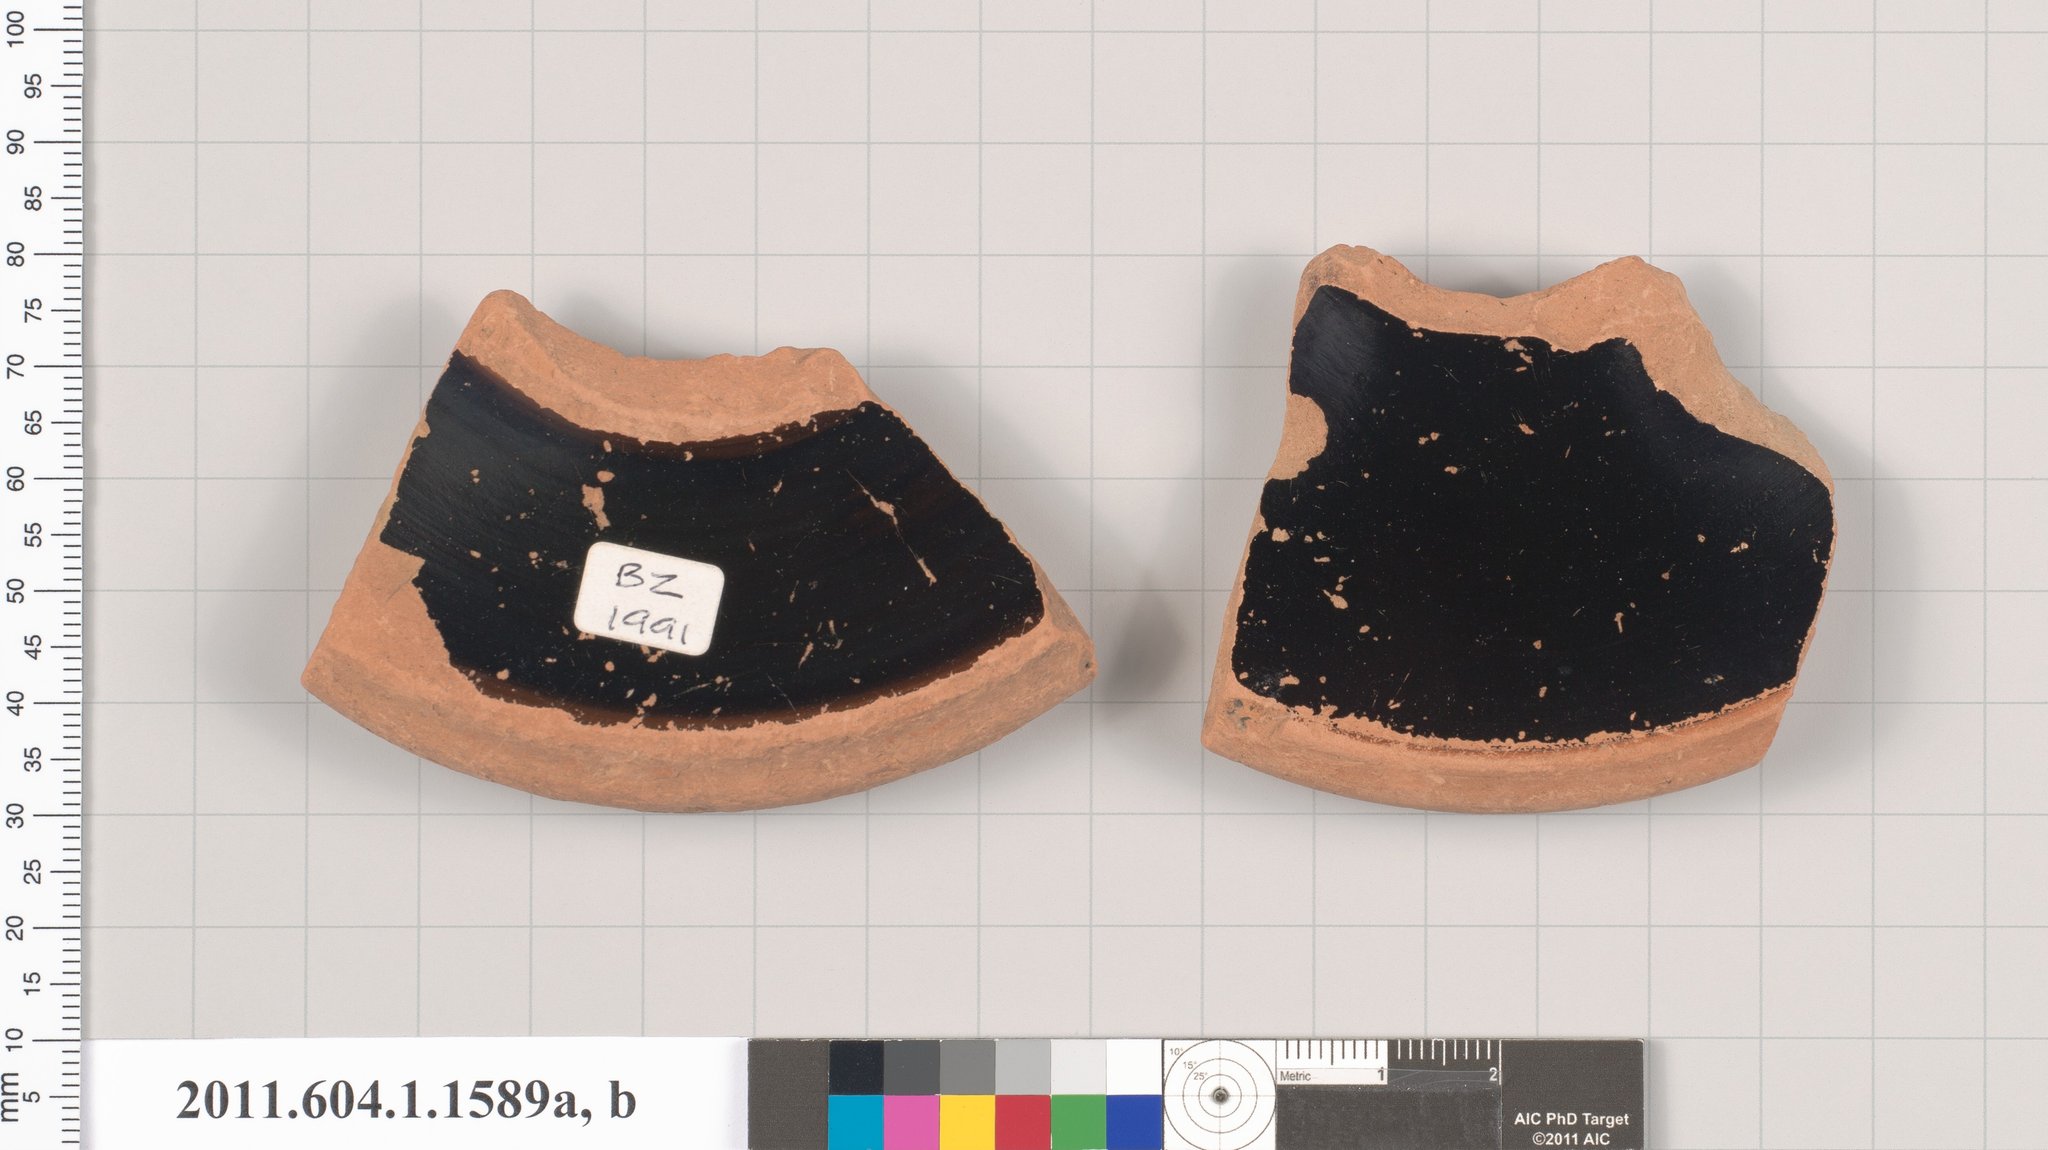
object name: kylix fragment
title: Terracotta fragments of kylikes (drinking cups)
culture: greek, attic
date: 500-401 BCE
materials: terracotta